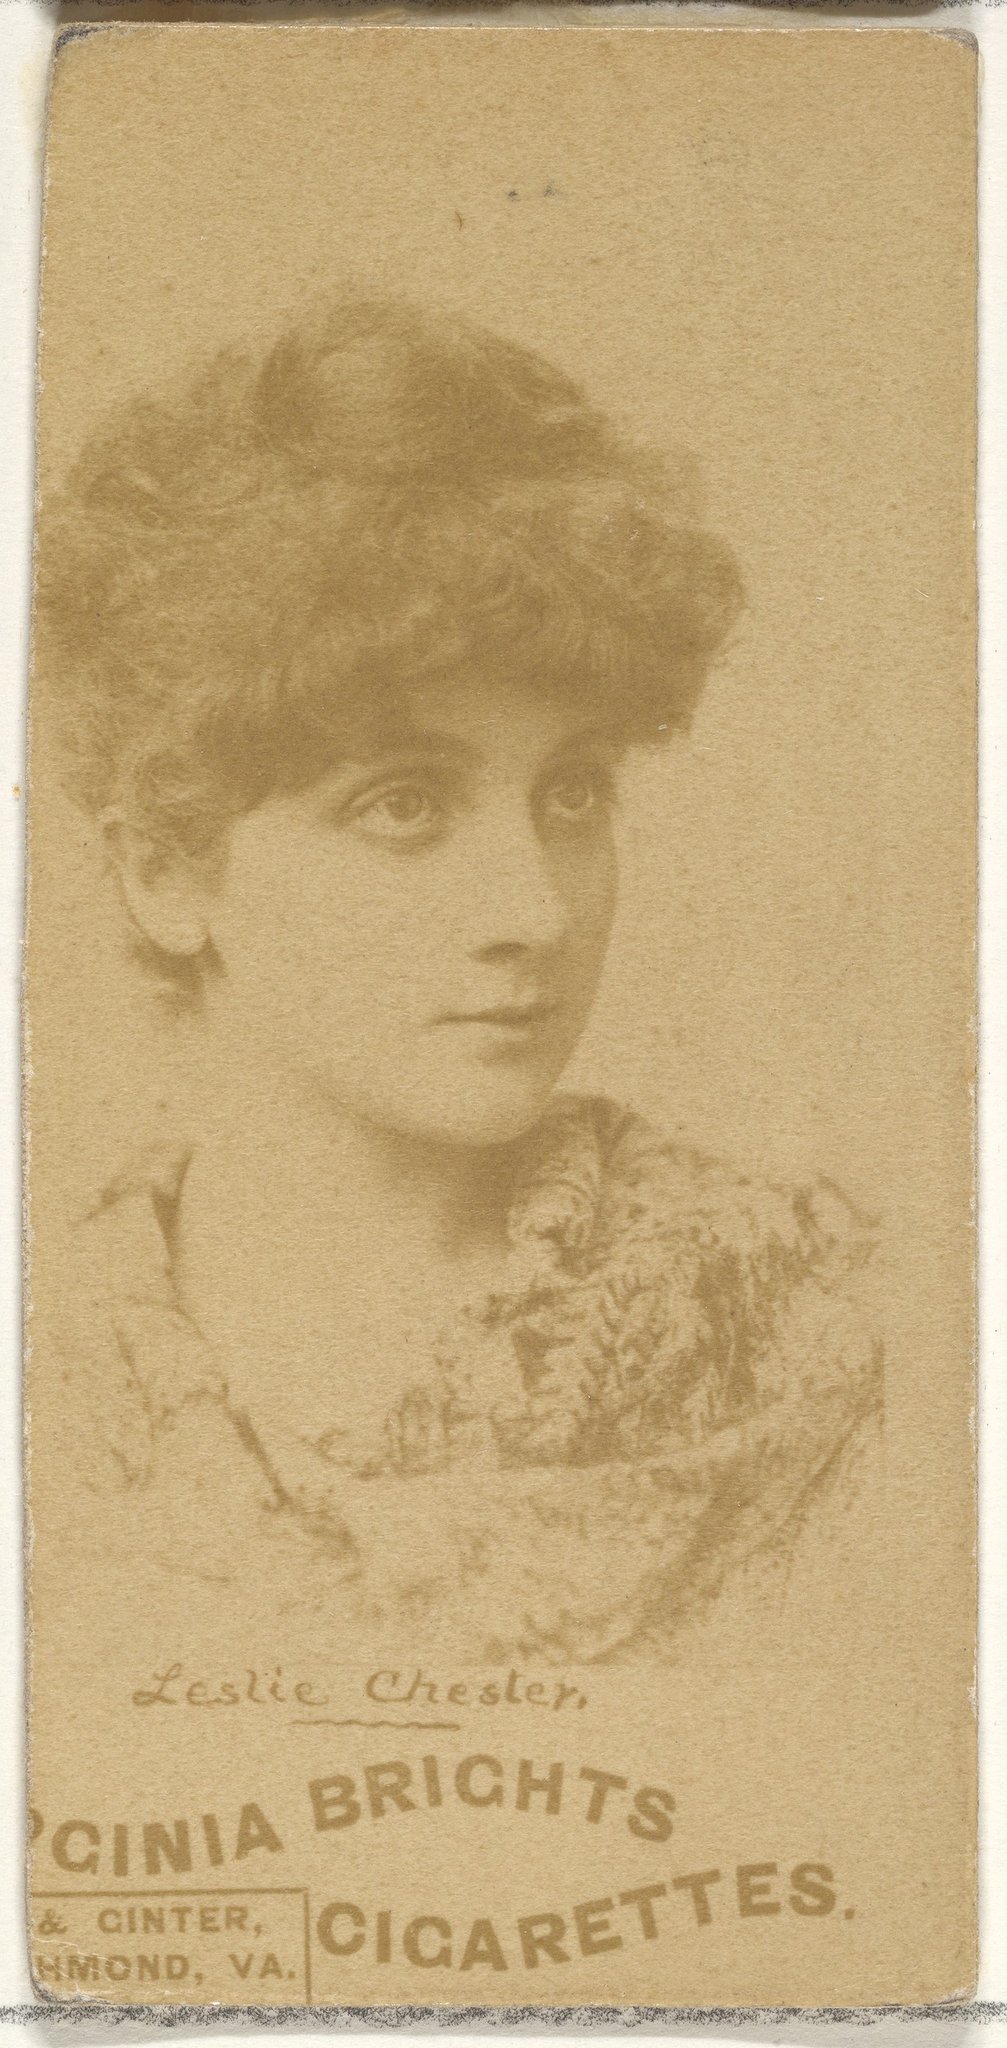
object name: photograph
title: Leslie Chester, from the Actors and Actresses series (N45, Type 1) for Virginia Brights Cigarettes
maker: allen & ginter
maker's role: publisher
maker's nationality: american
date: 1888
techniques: albumen silver print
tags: portraits,women,actresses